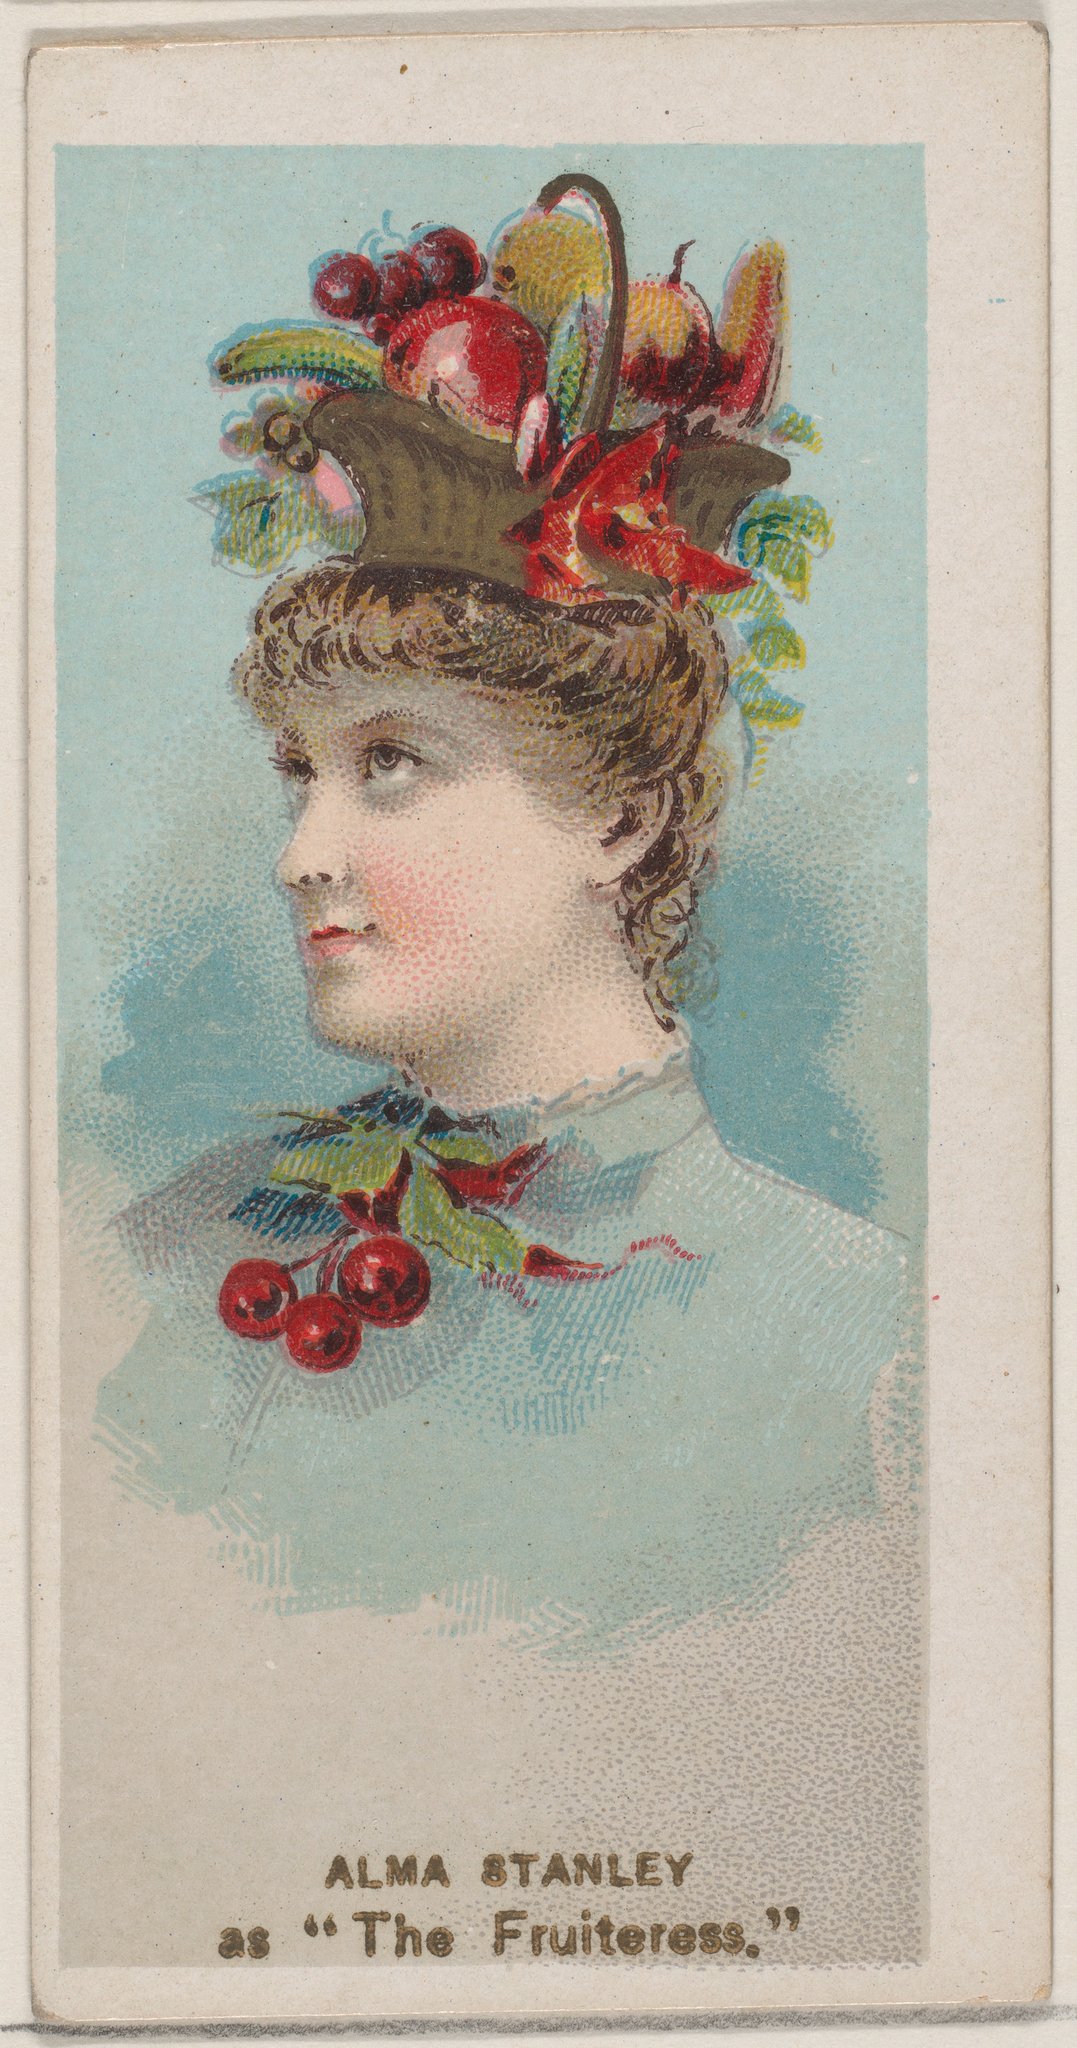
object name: print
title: Alma Stanley as "The Fruiteress," from the series Fancy Dress Ball Costumes (N73) for Duke brand cigarettes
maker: w. duke, sons & co.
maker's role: publisher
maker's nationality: american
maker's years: 1870-1920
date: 1889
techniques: color lithograph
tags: women,actresses